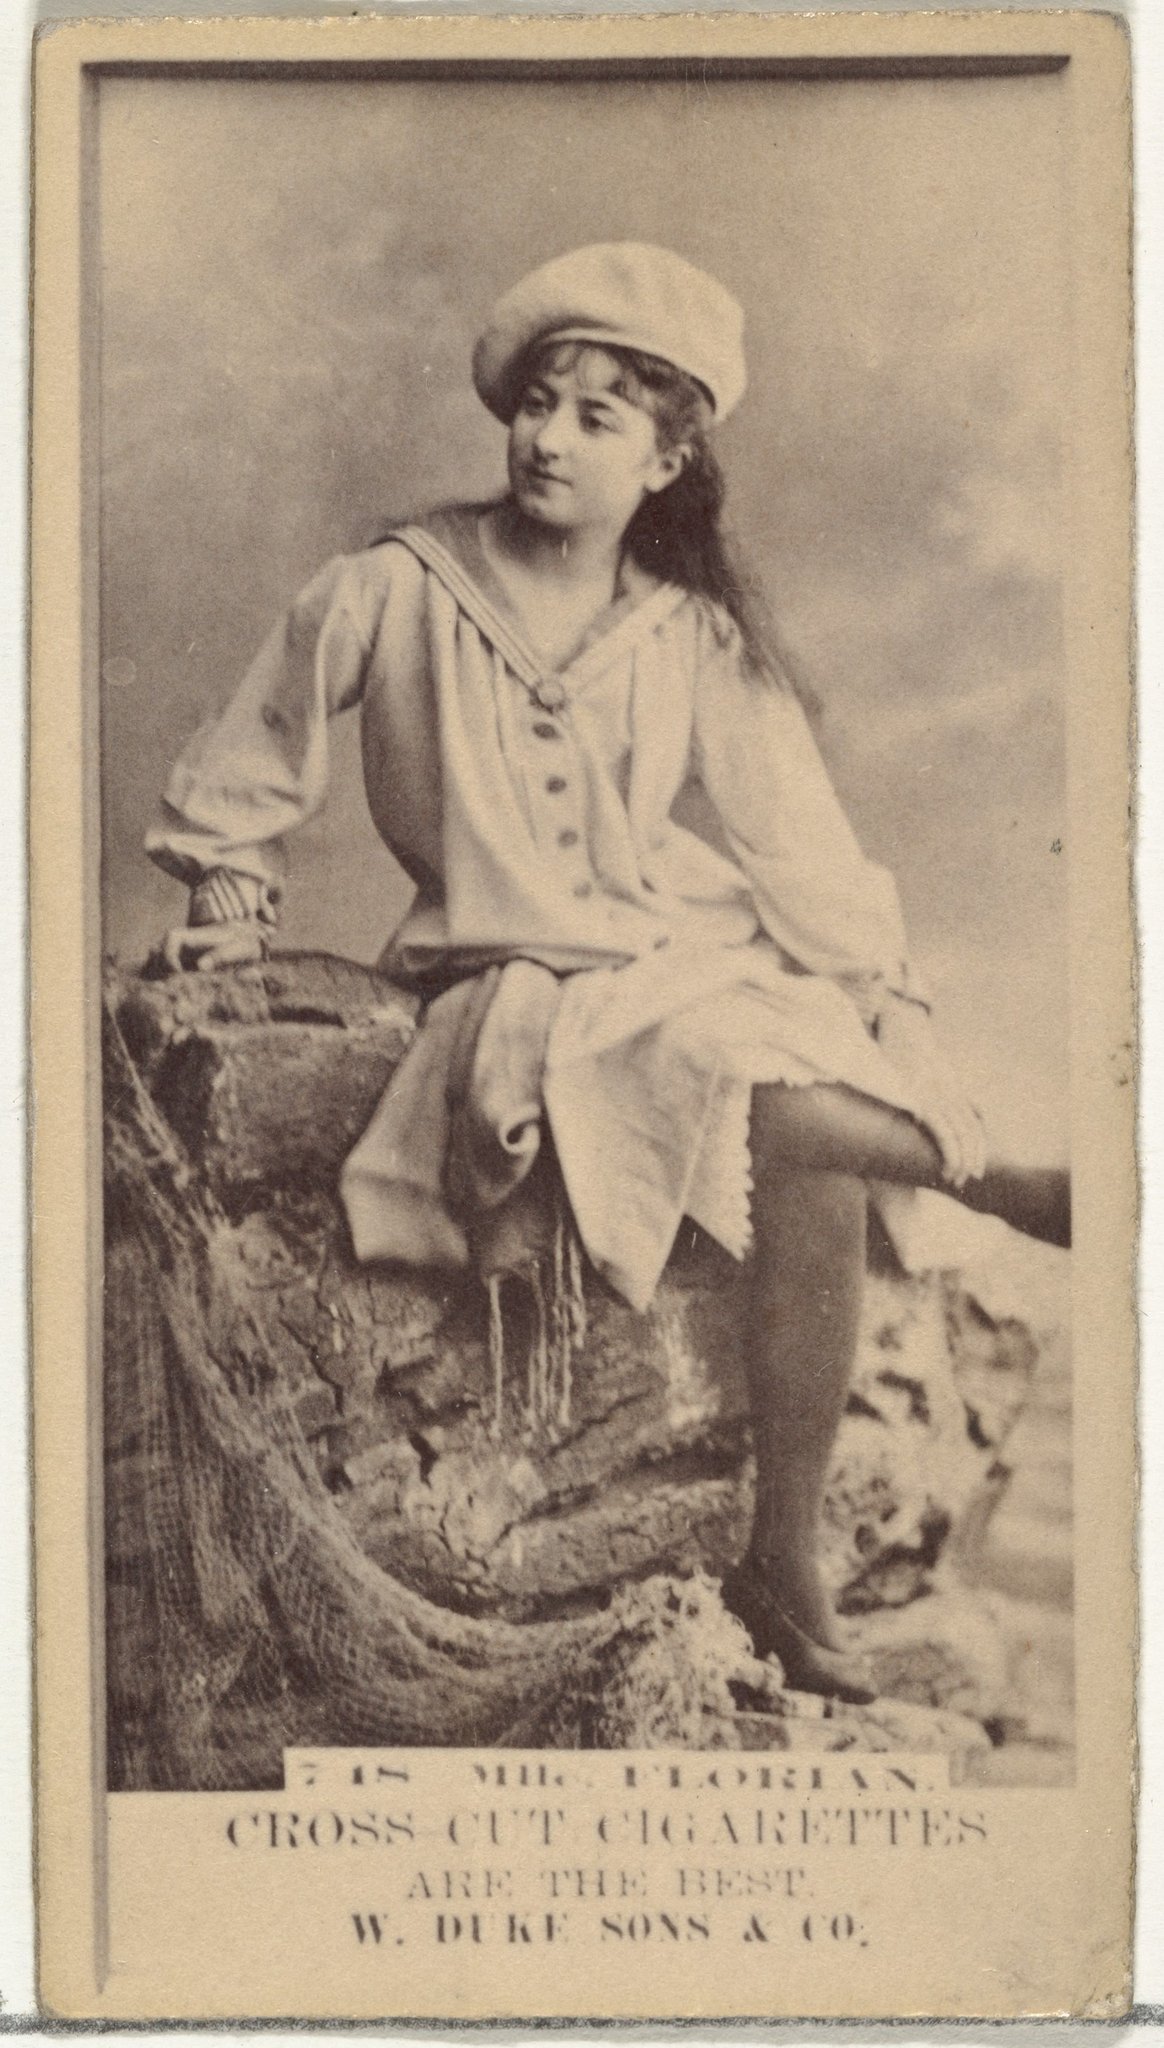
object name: photograph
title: Card Number 718, Miss Florian, from the Actors and Actresses series (N145-3) issued by Duke Sons & Co. to promote Cross Cut Cigarettes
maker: w. duke, sons & co.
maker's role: publisher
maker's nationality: american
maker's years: 1870-1920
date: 1880-1889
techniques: albumen silver print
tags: portraits,women,actresses